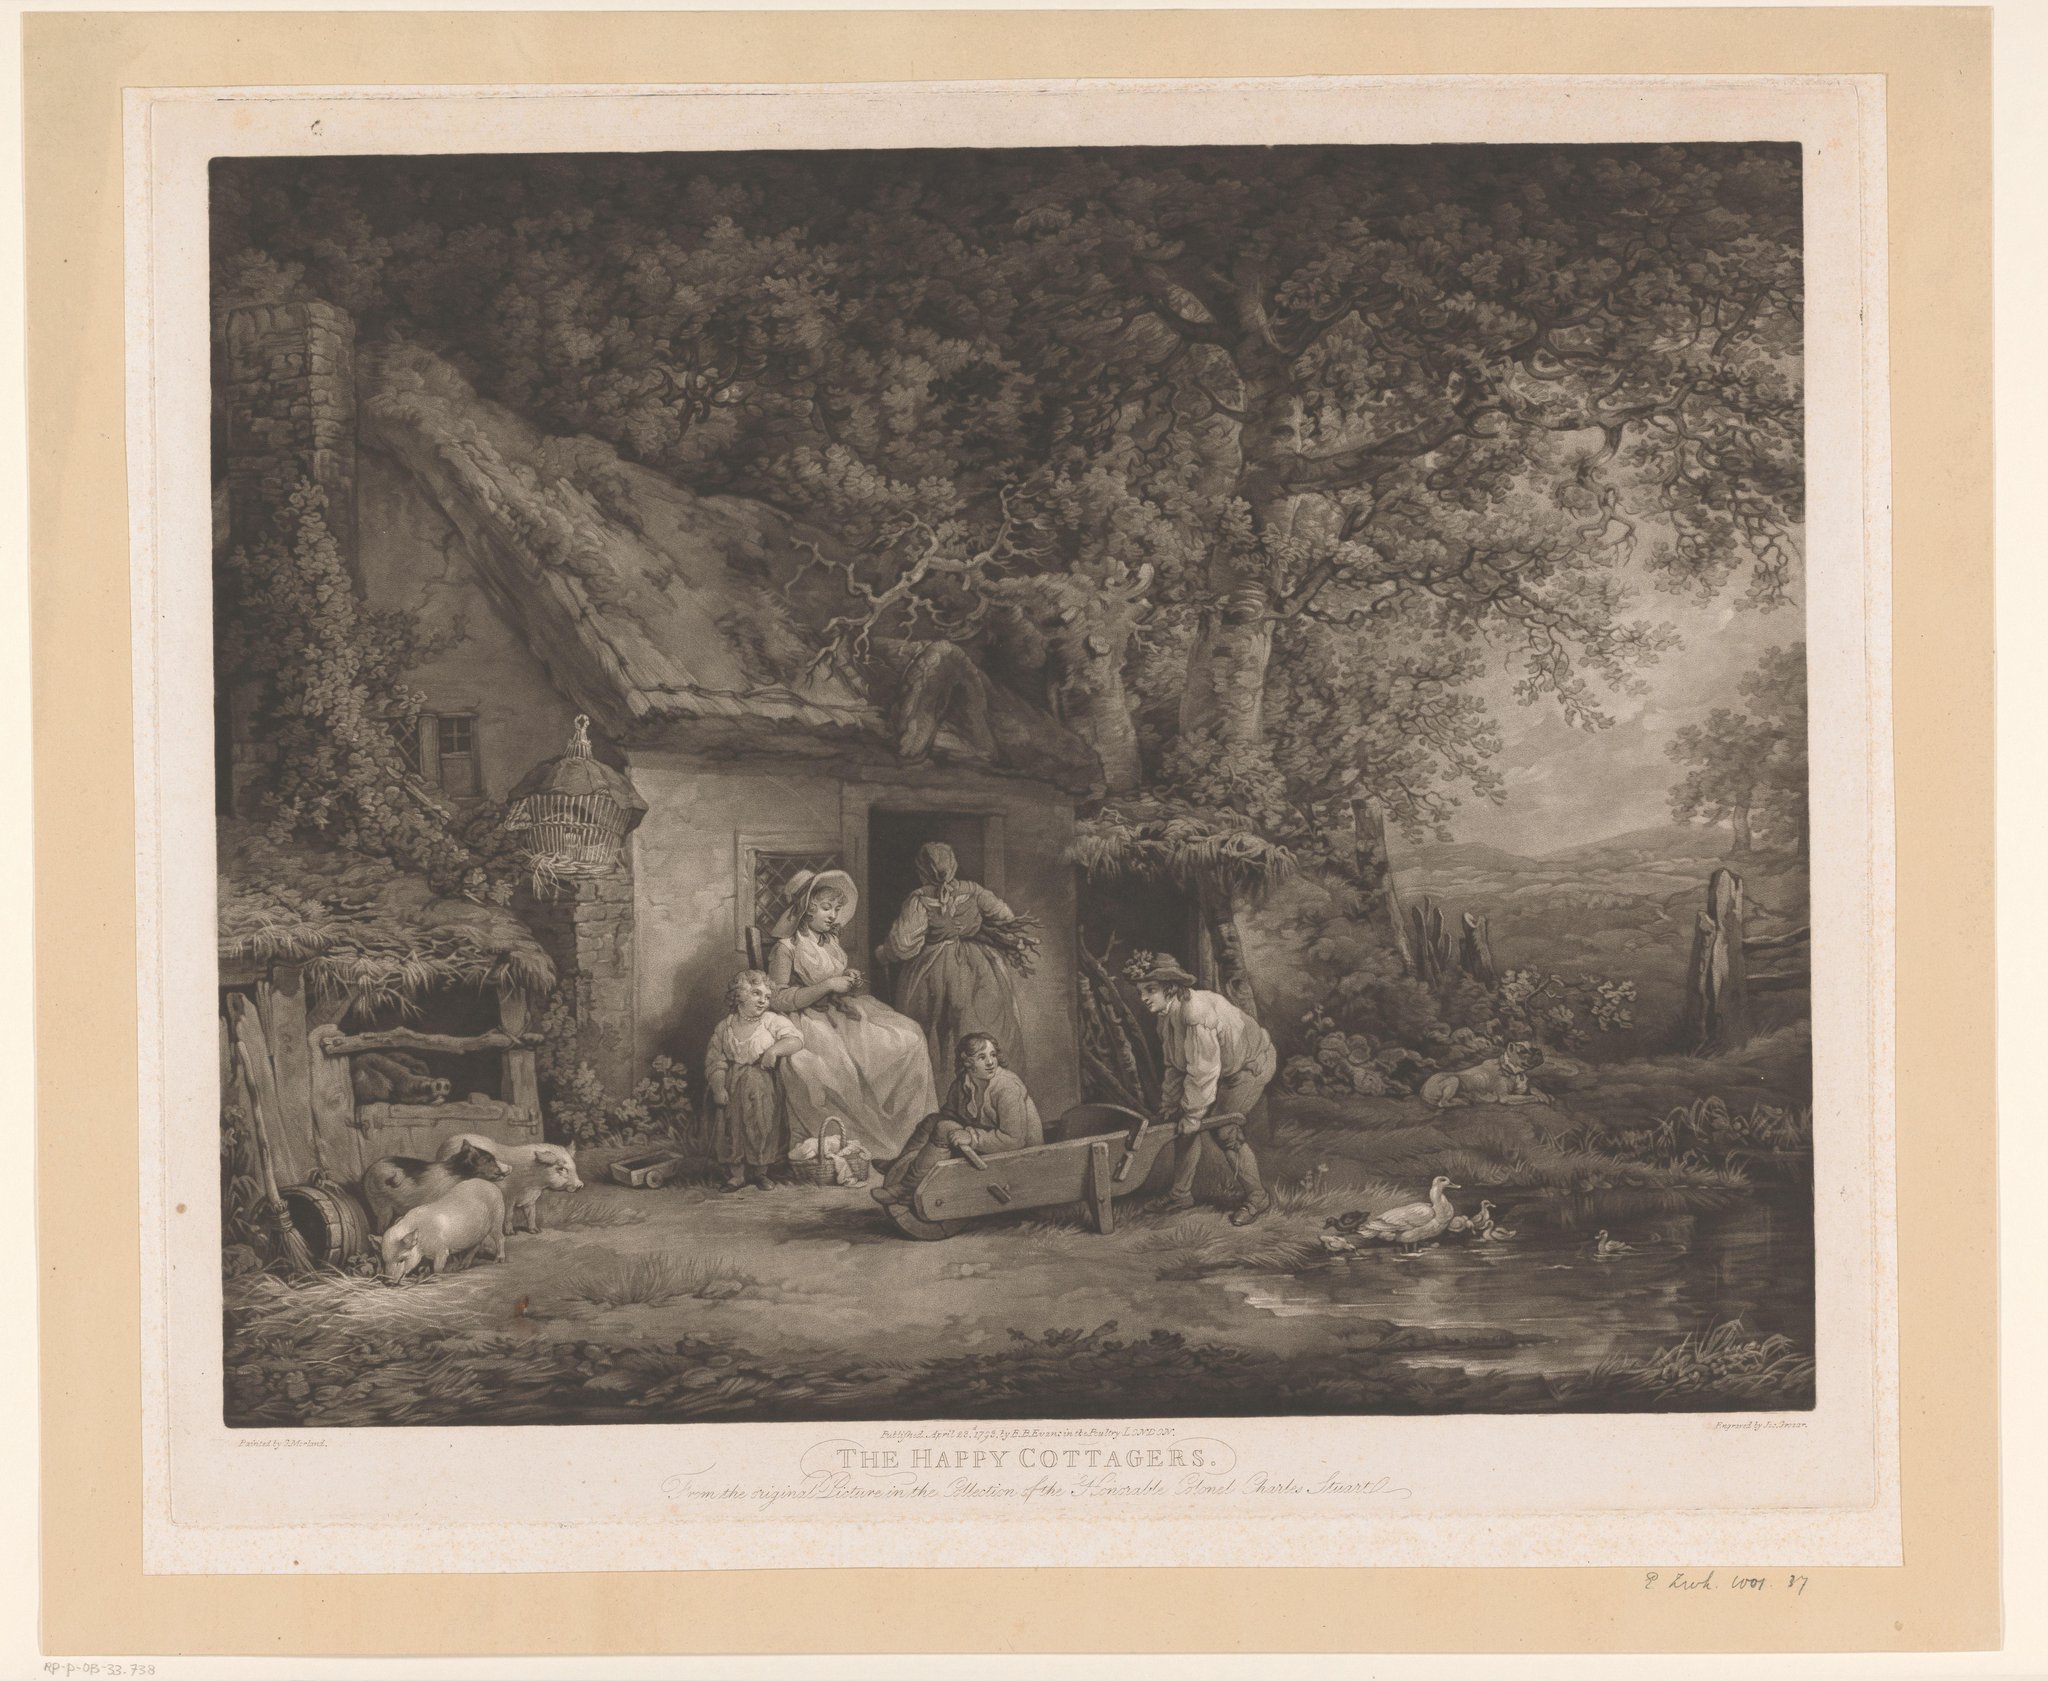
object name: print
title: The Happy Cottagers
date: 1798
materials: paper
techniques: engraving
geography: london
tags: cottage, family life at home, (other forms of) needlework, e.g.: crocheting, knitting, embroidering, fringe, edge of the wood (+ landscape with figures, staffage)